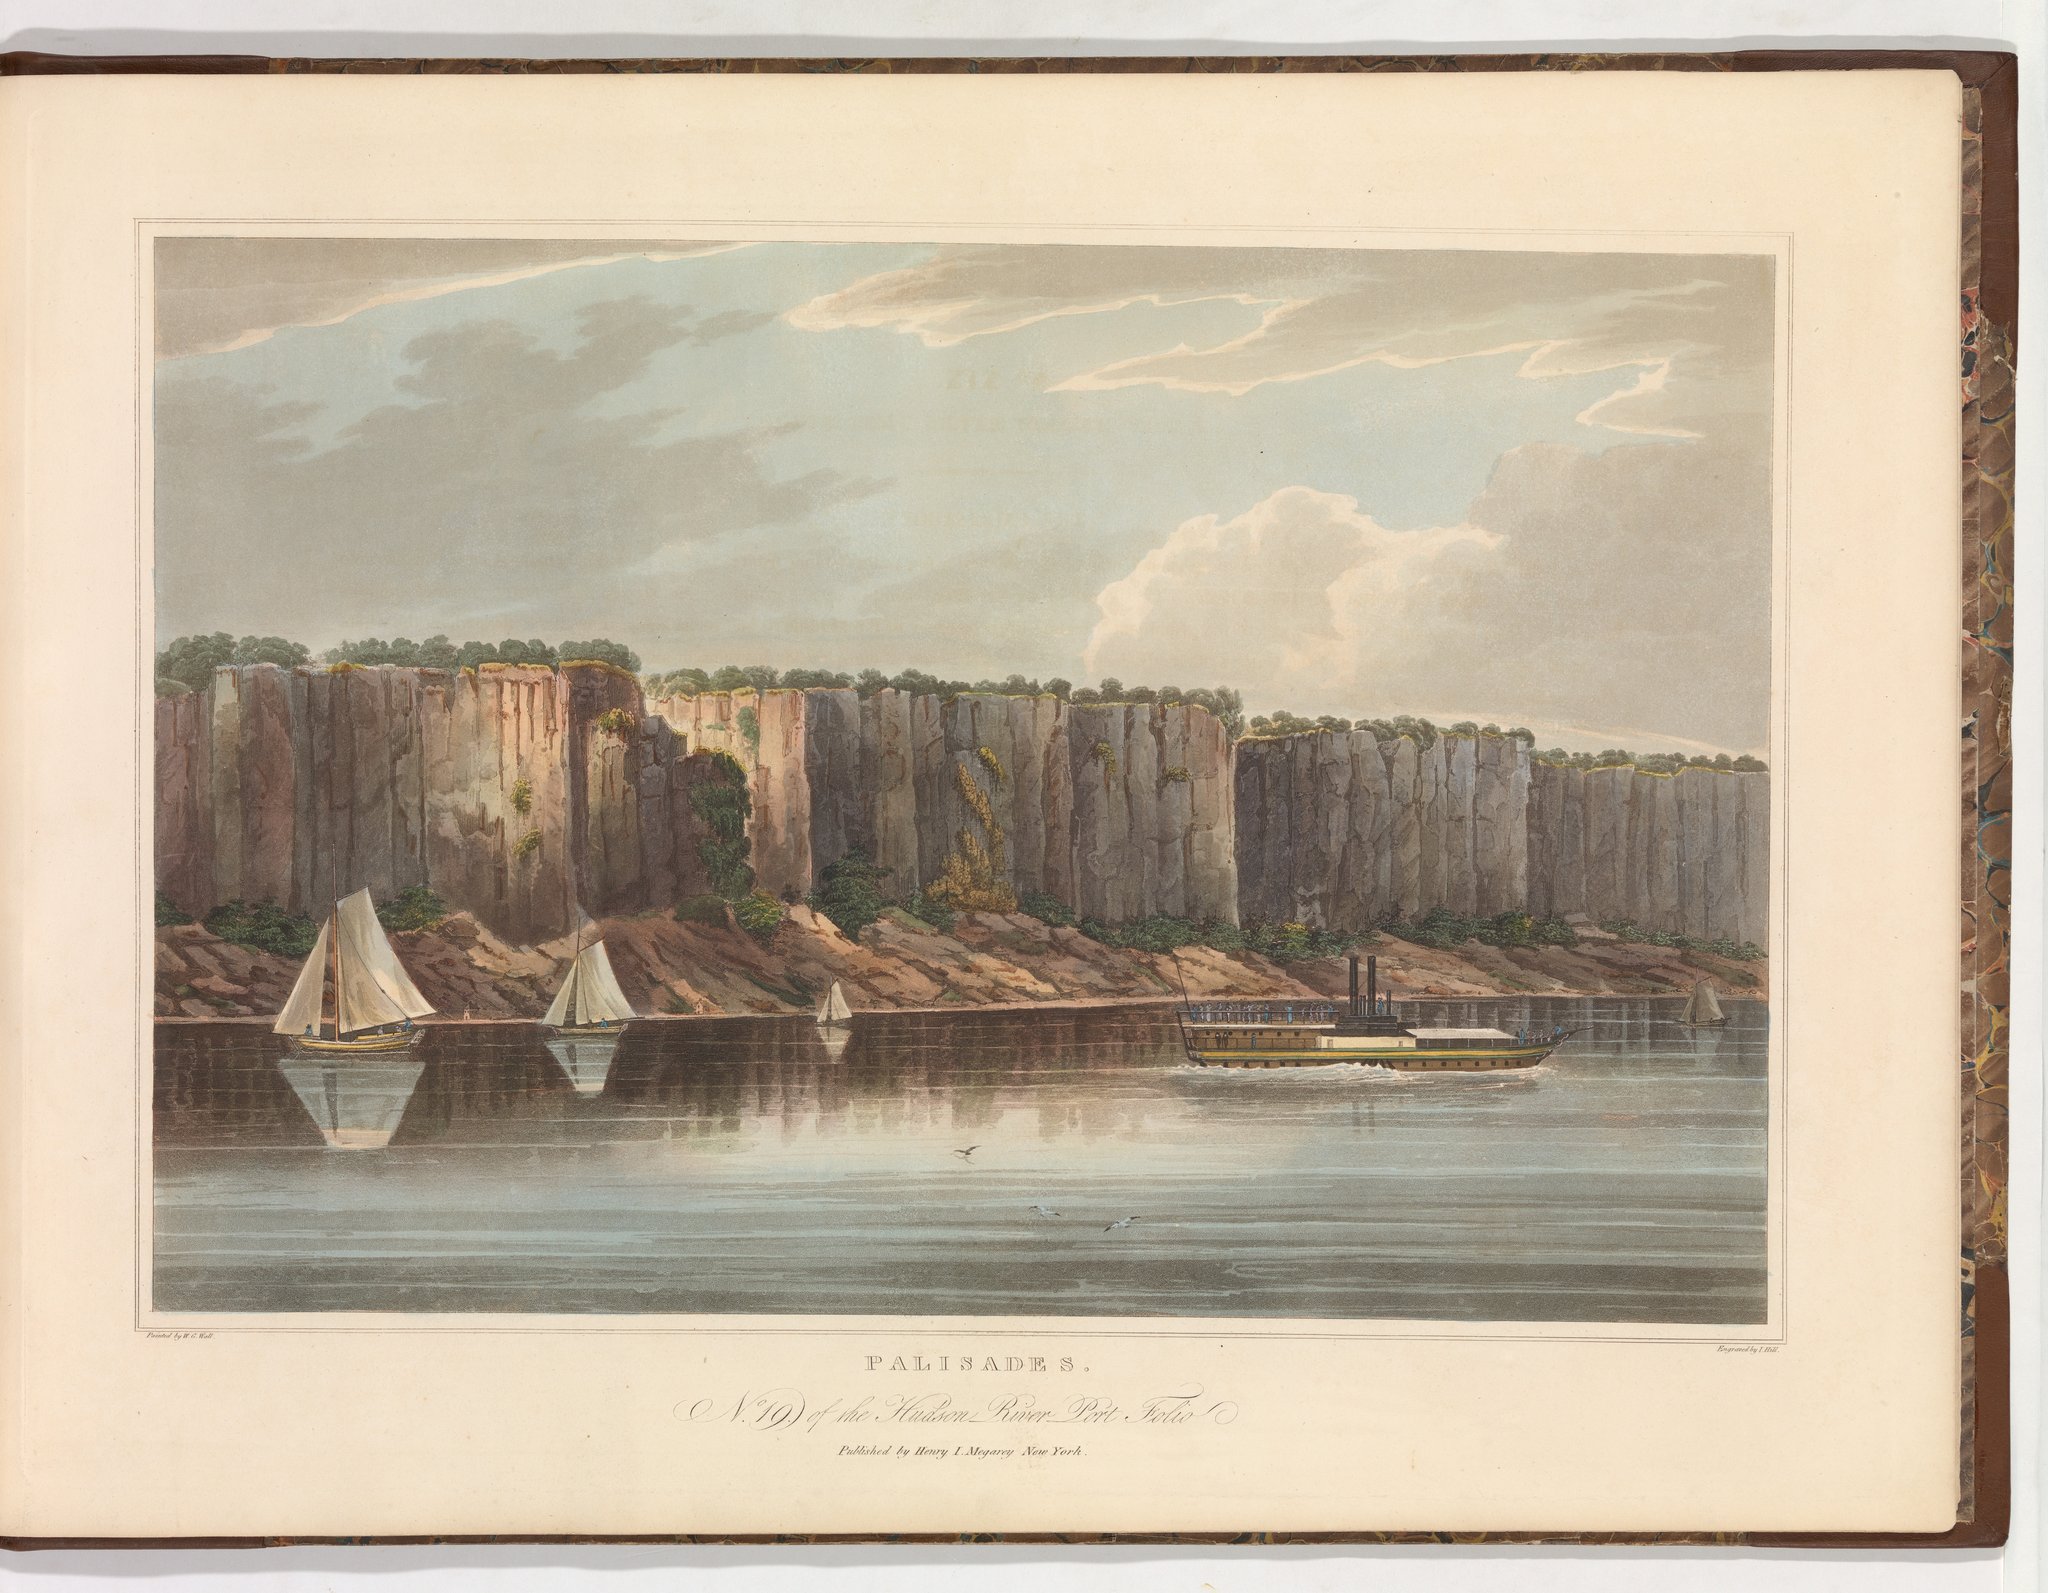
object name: print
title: The Palisades (No. 19 of The Hudson River Portfolio)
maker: john hill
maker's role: etcher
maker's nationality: american, born england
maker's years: 1770-1850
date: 1823-1824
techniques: aquatint, hand coloring, printing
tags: rivers,landscapes,boats